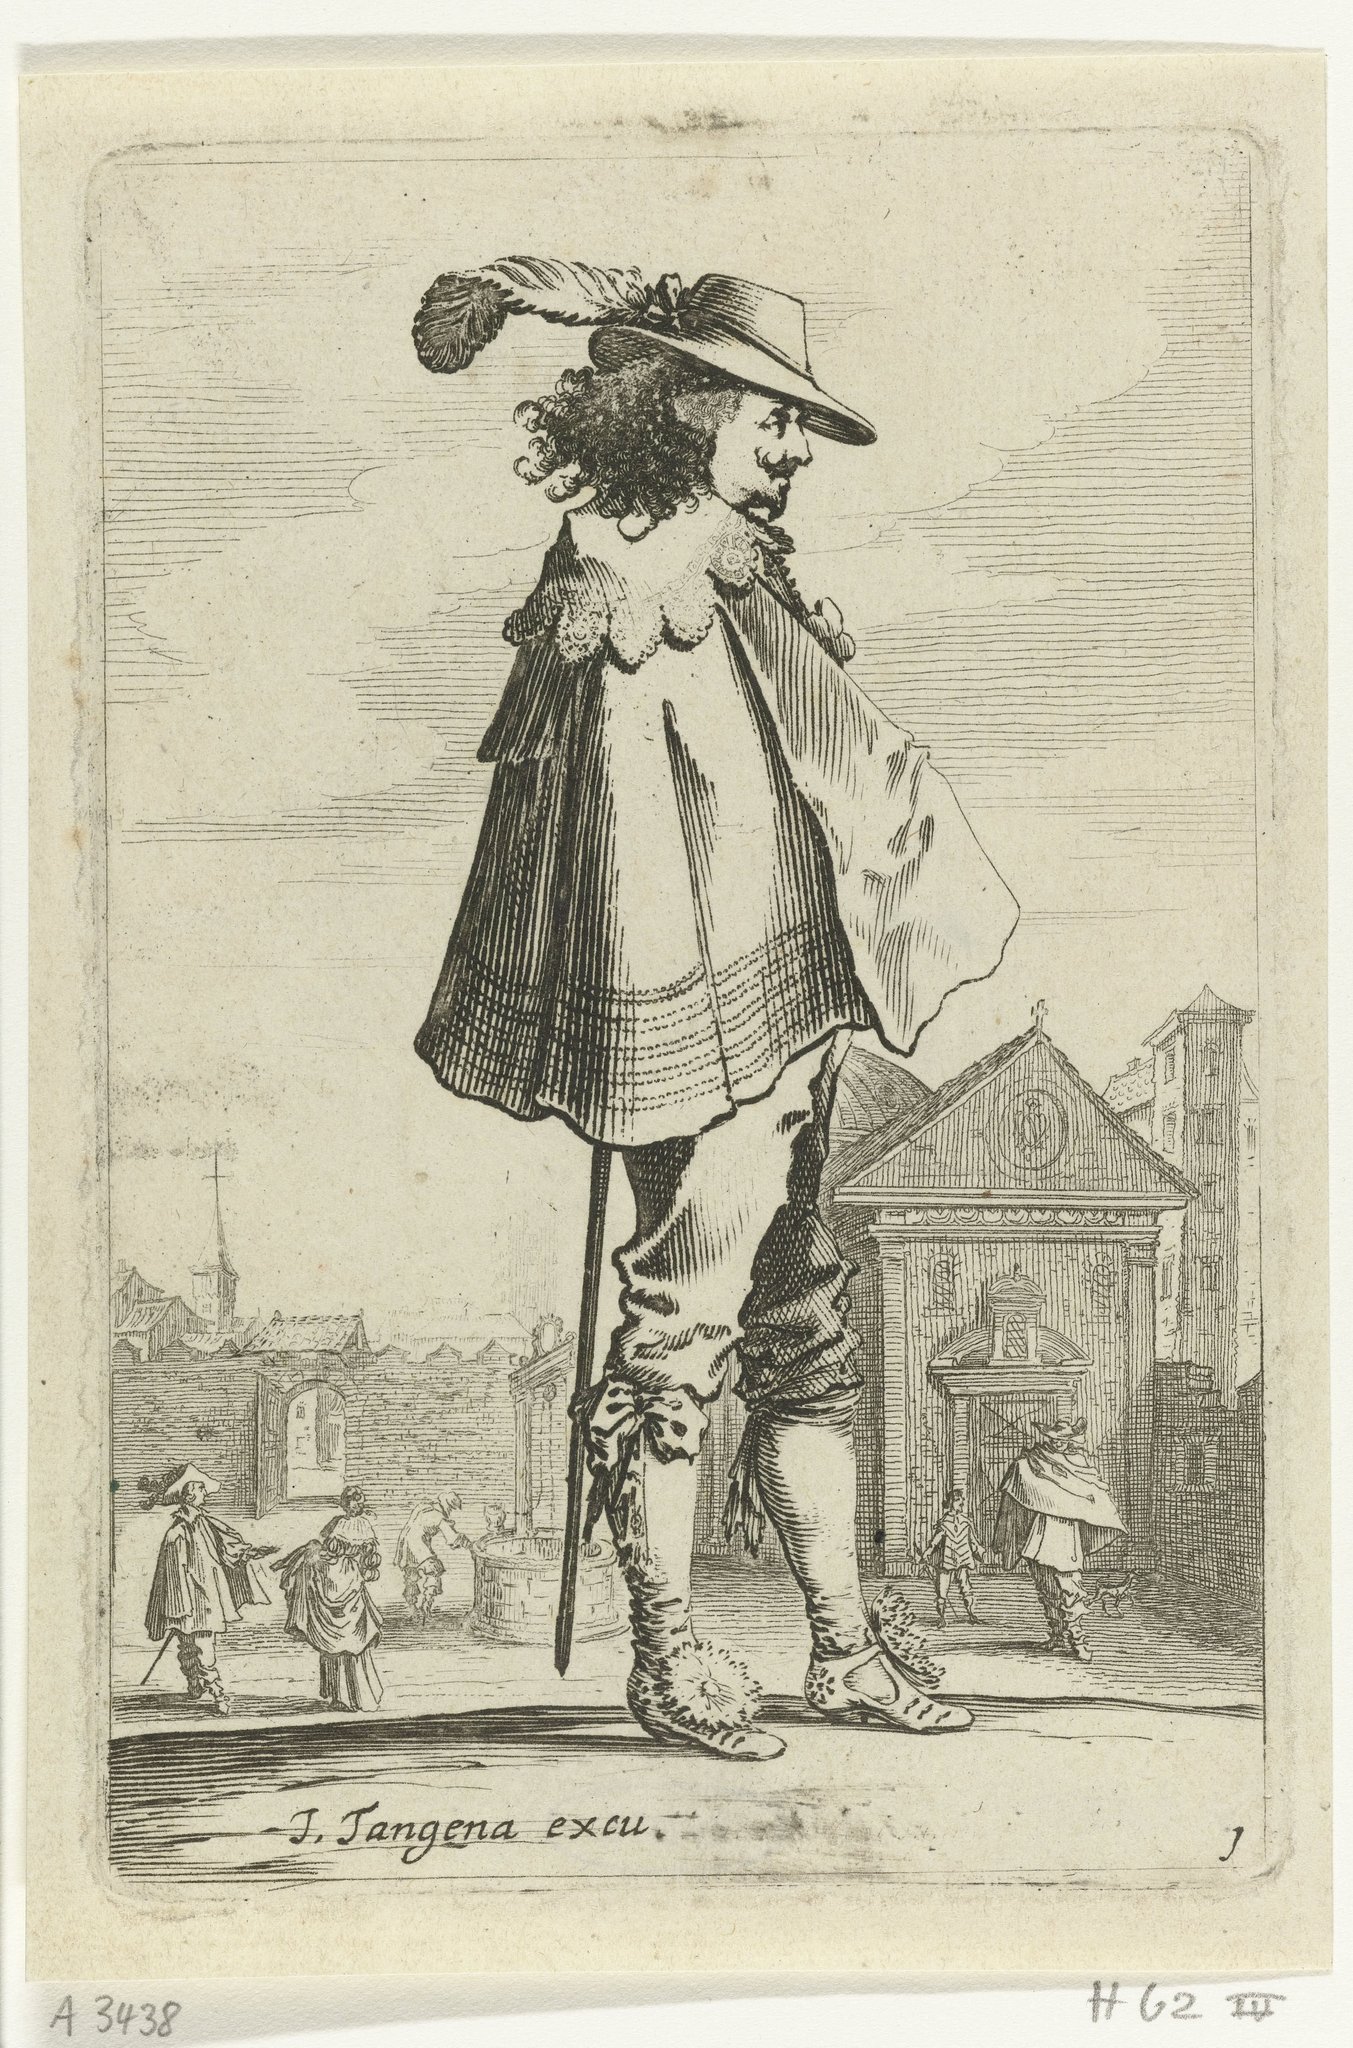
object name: costume print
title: Staande officier en profil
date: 1687-1691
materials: paper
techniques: engraving, etching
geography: amsterdam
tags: church (exterior), clothes, costume (+ men's clothes), officer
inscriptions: collector's mark: Lugt 2228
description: Officier, en profil. Op de achtergrond een kerk en figuren. De prent maakt deel uit van een tiendelige serie met voorstellingen van gewapende officieren en soldaten, gekleed volgens de Nederlandse mode ca. 1625-1635.